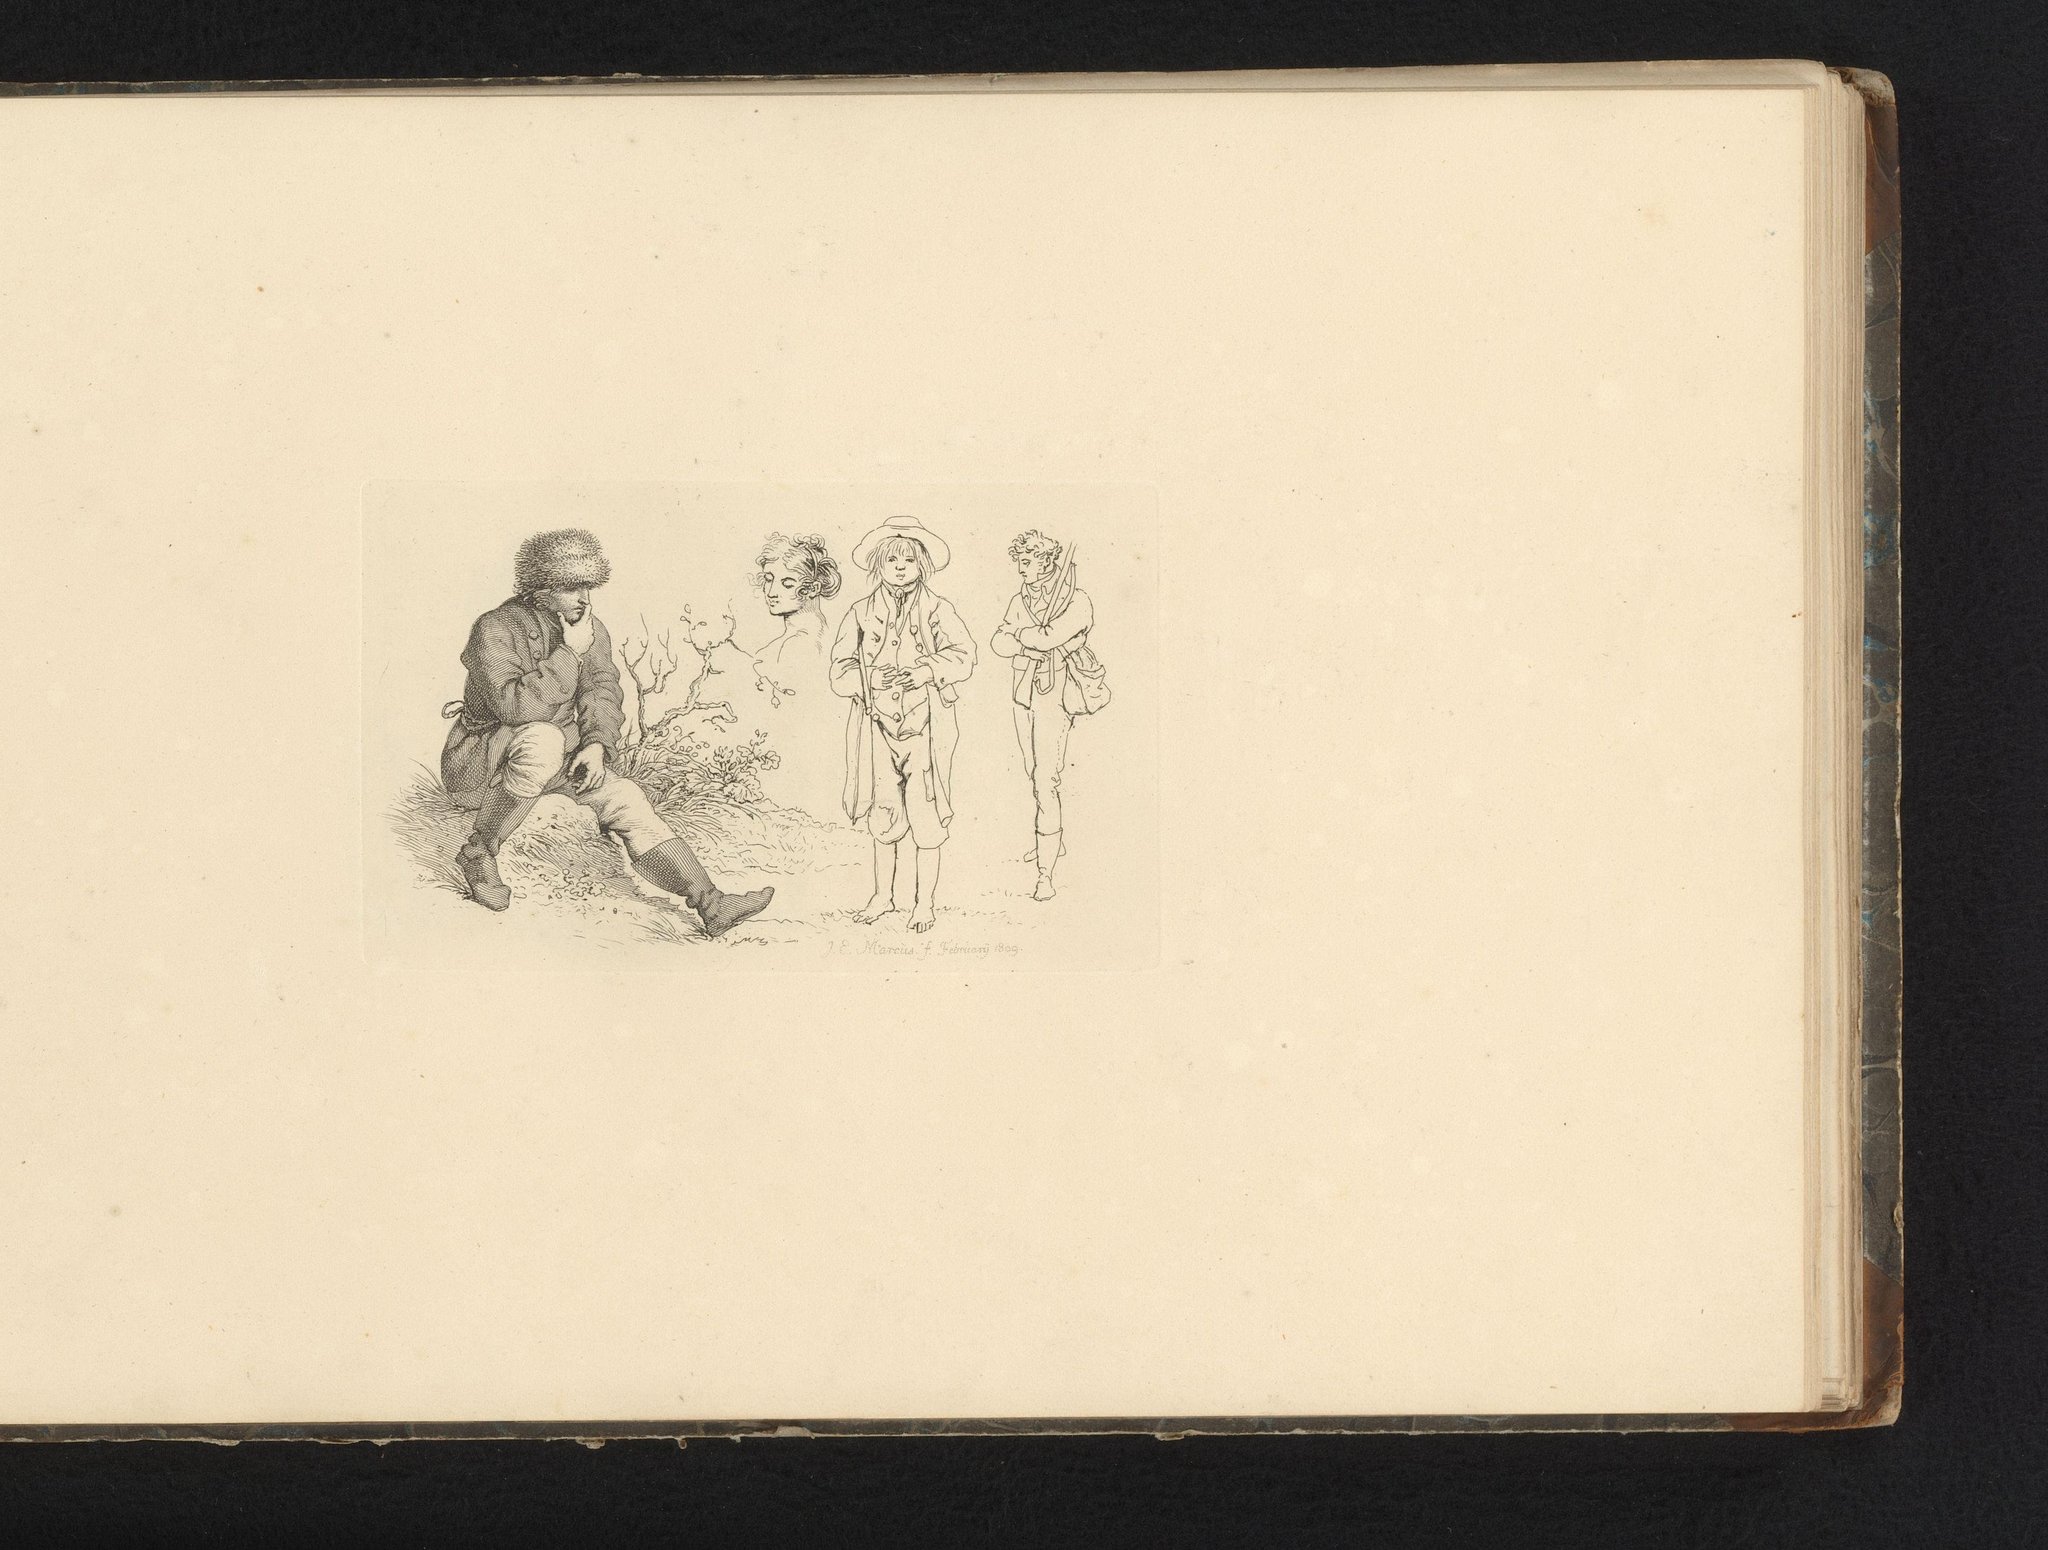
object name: album leaf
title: Studieblad met zittend figuur, twee staande figuren en een portret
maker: jacob ernst marcus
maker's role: draughtsman, print maker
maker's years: 1774-1826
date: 1802-1809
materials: paper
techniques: etching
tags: boy (child between toddler and youth), hunter, sitting on the ground, anonymous historical person portrayed - bb - woman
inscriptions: date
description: Deze prent maakt deel uit van een album.